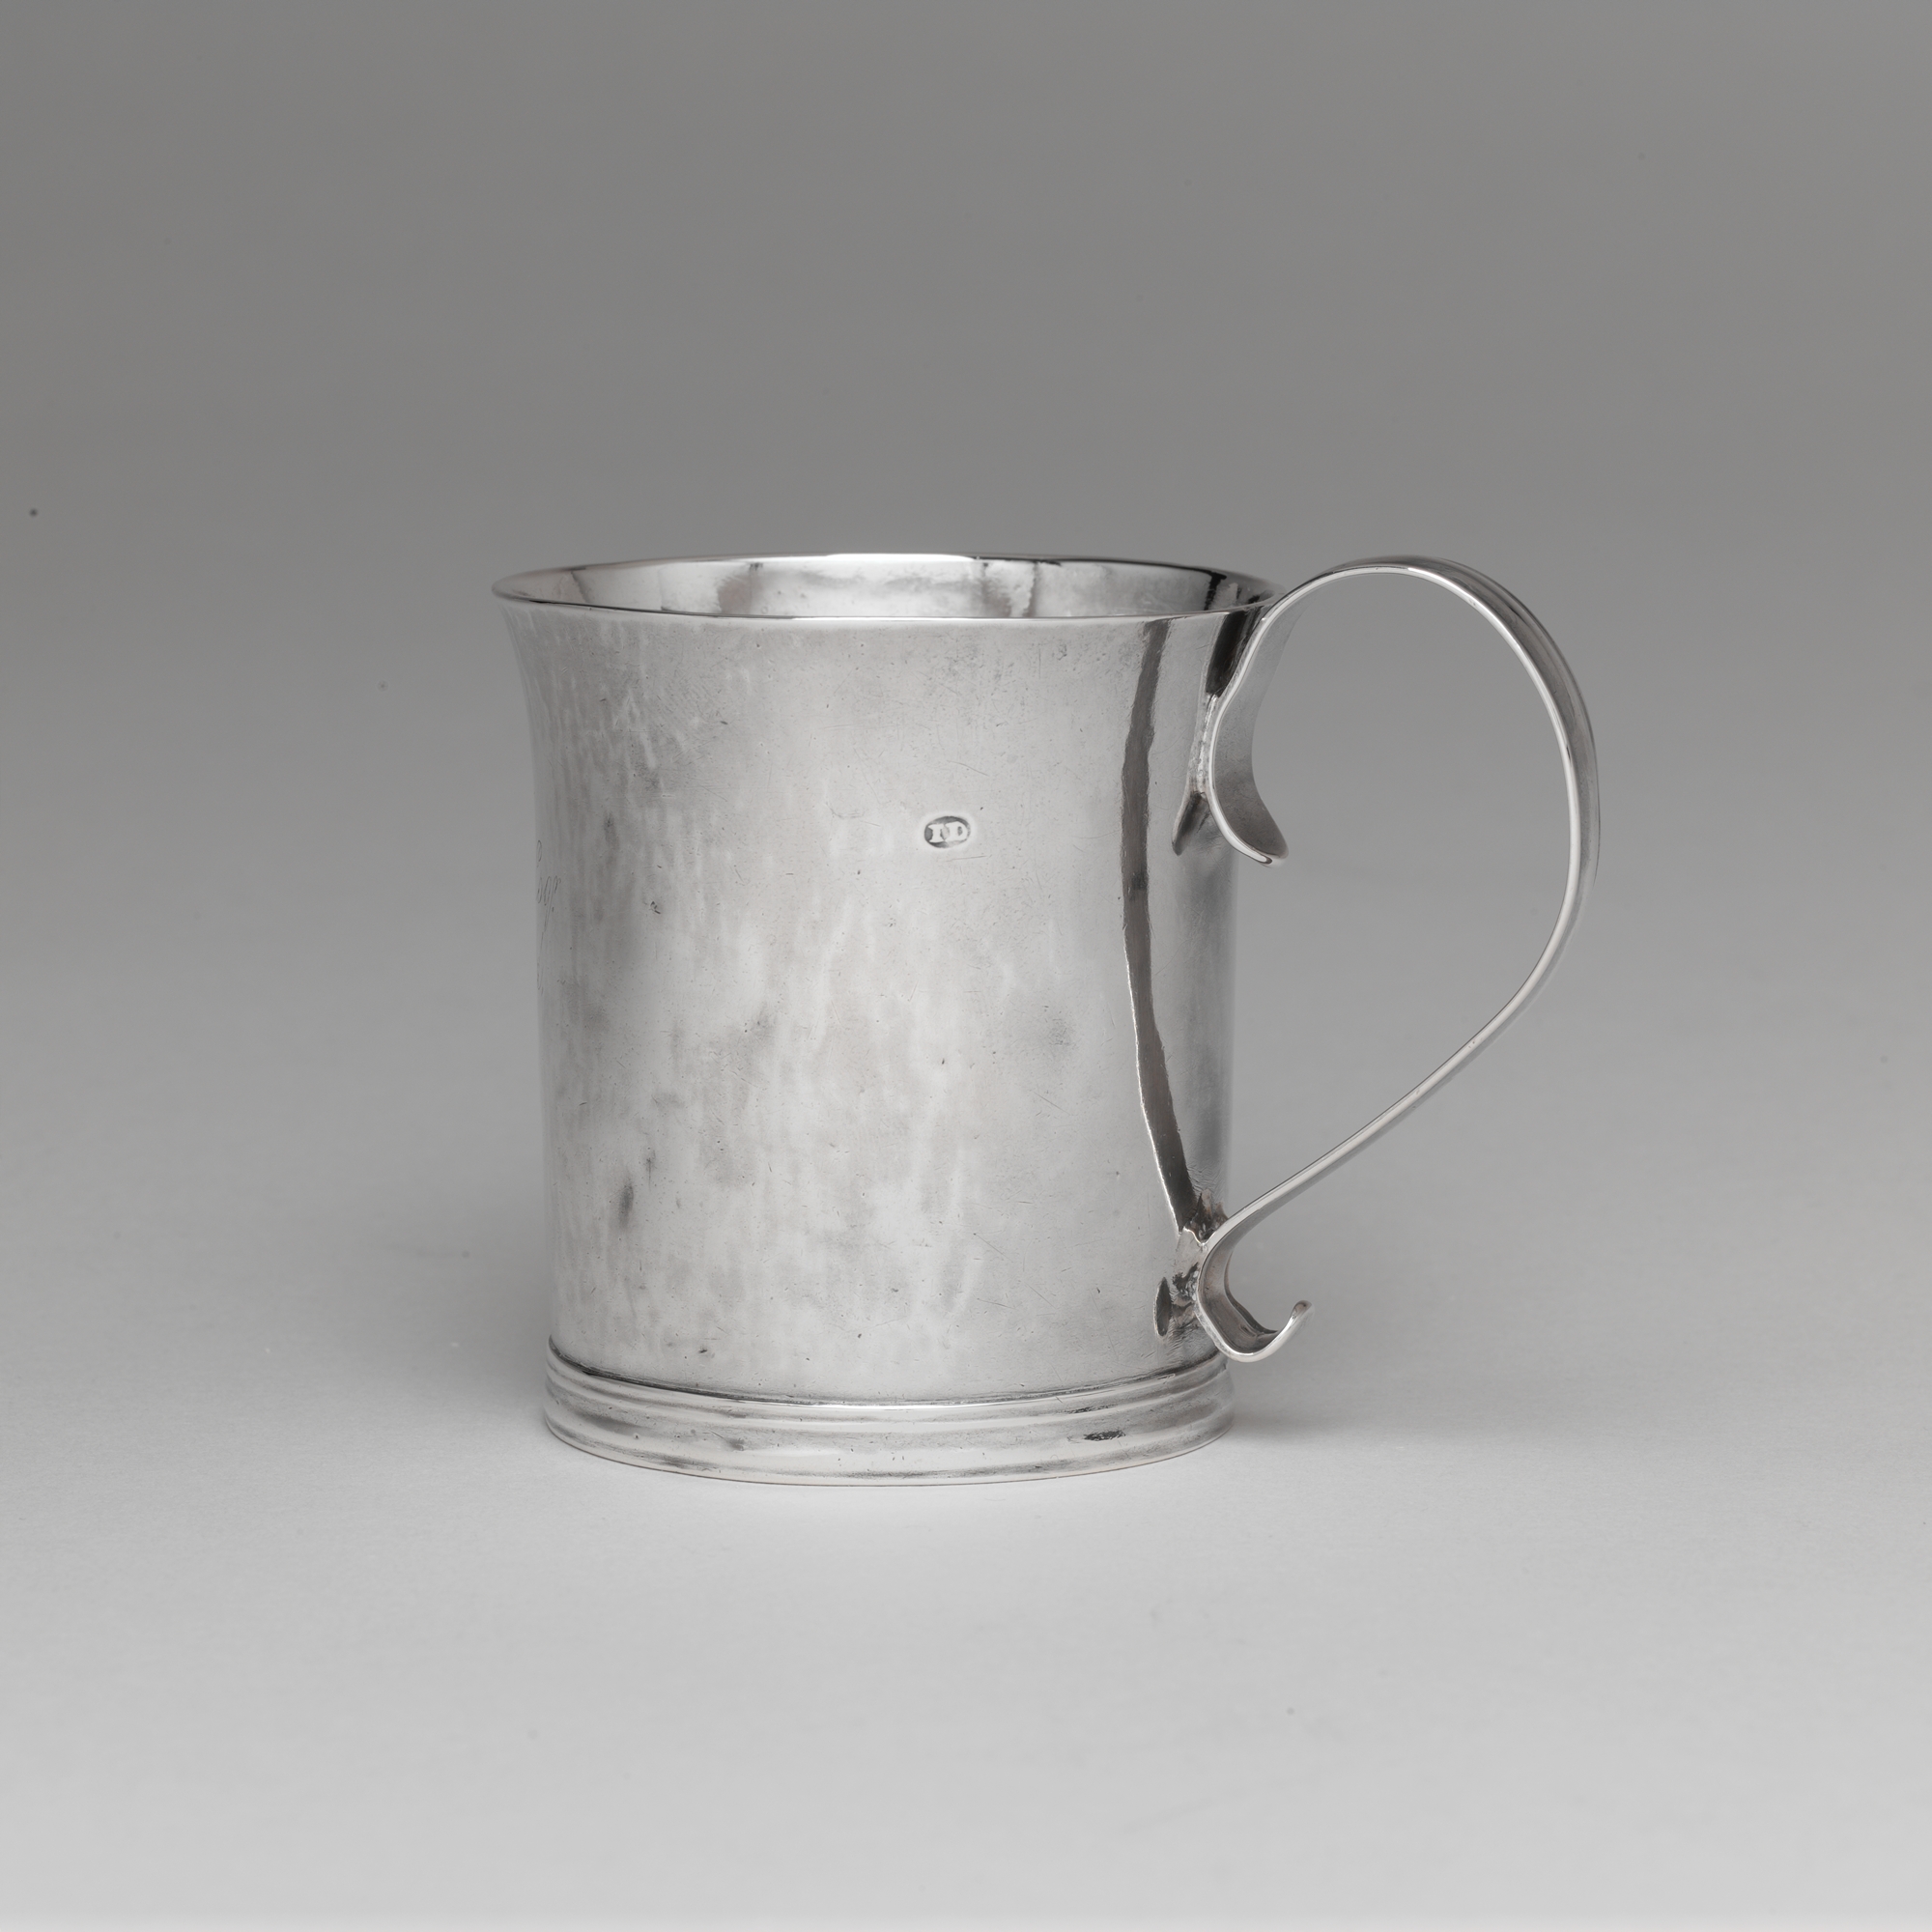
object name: cup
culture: american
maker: john dixwell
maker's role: maker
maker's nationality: american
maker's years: 1680-1725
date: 1715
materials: silver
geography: united states